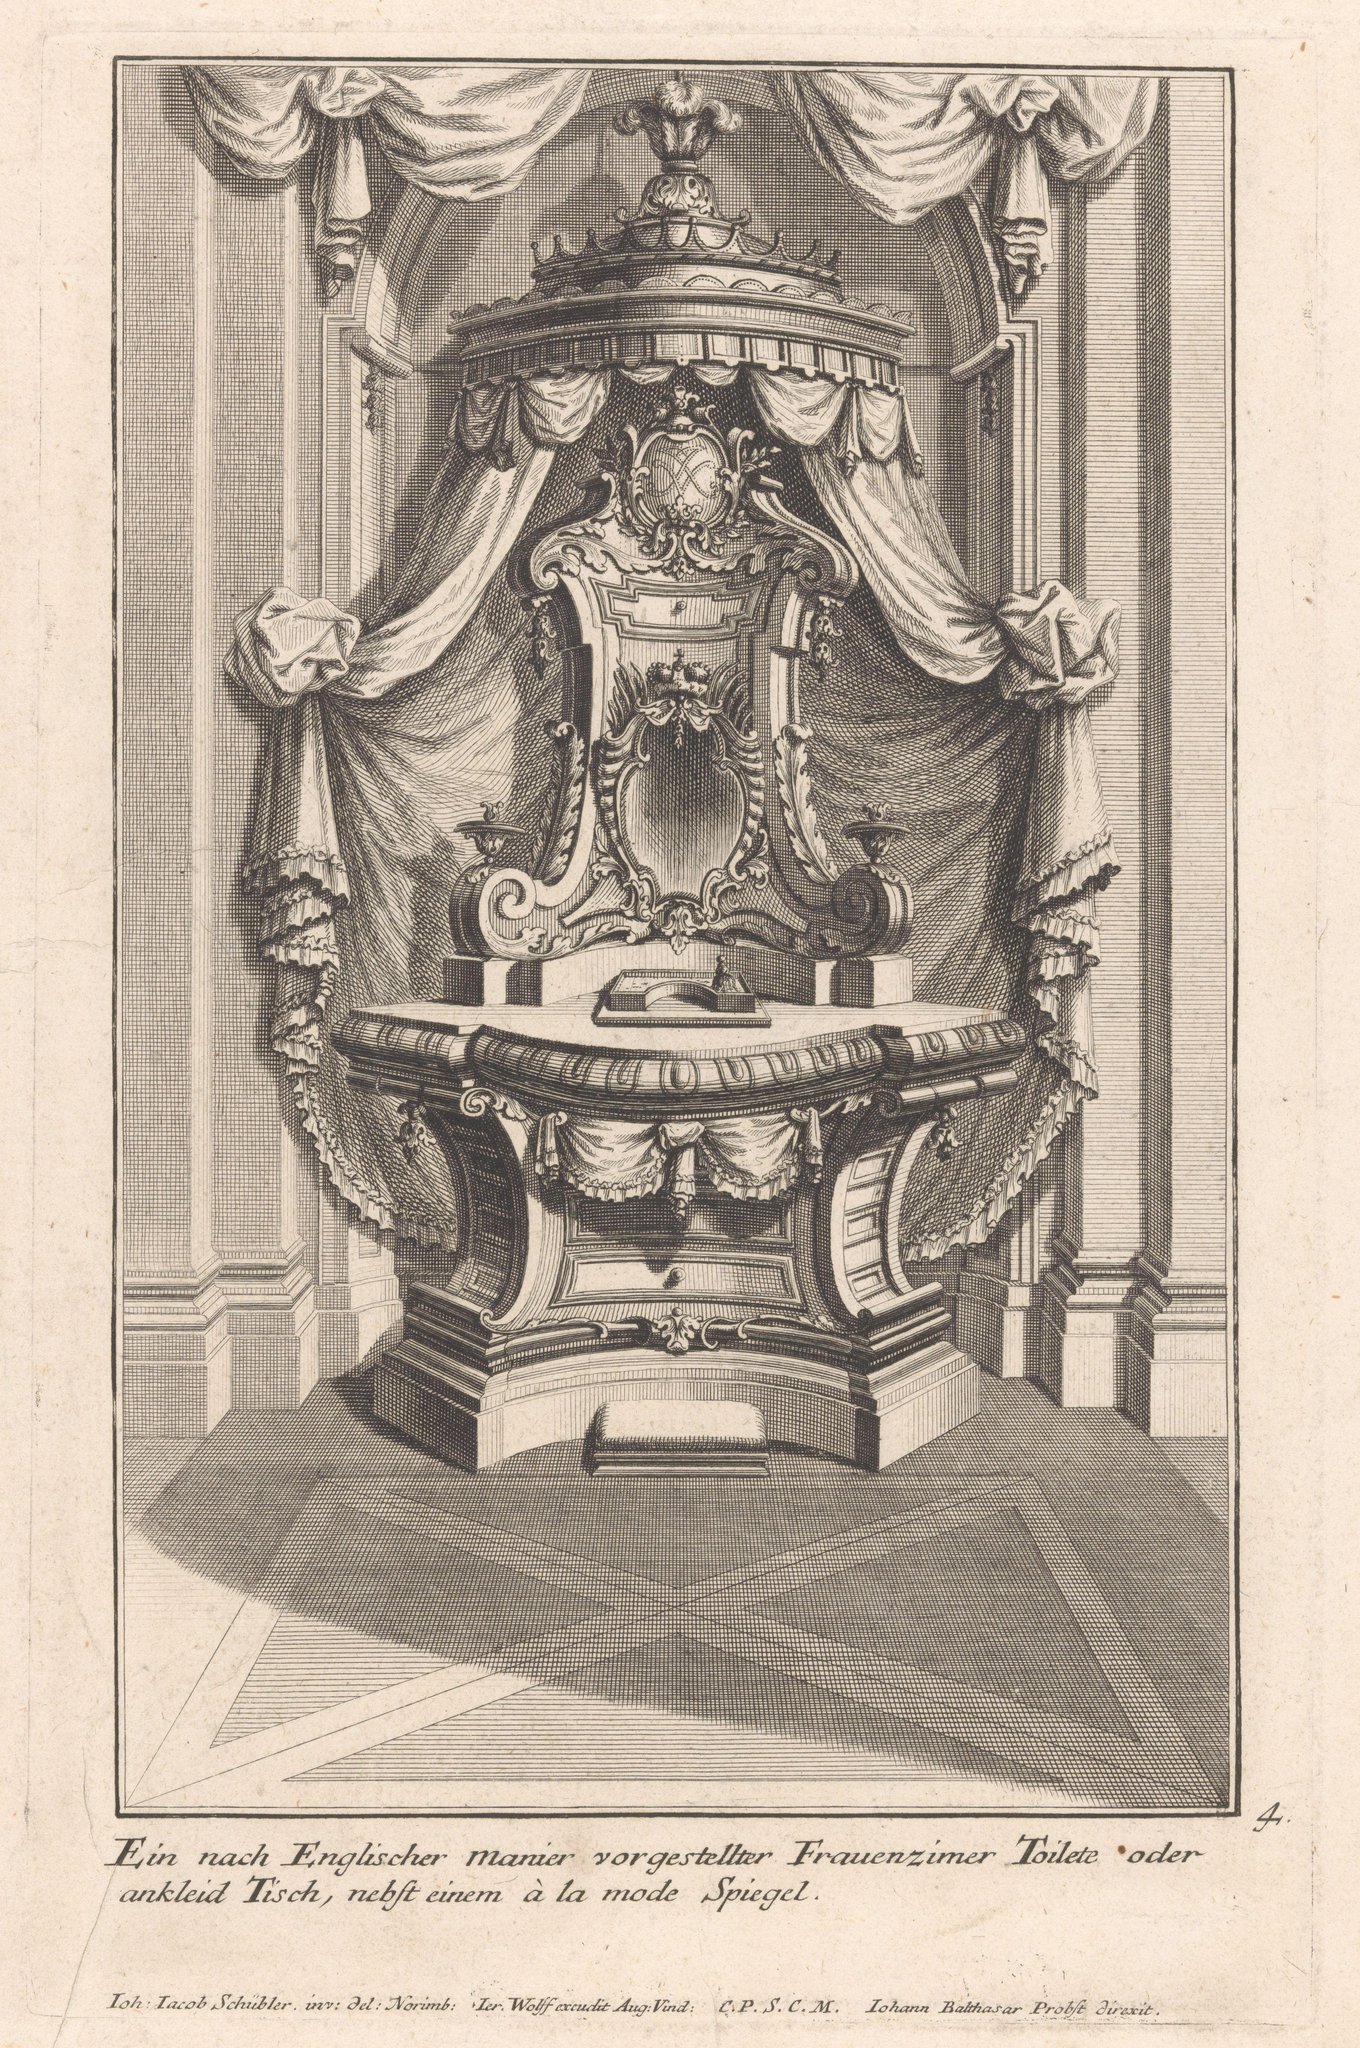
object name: ornament print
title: Johann Jacob Schüblers Vierdte Ausgab seines vorhabenden Wercks, Worinnen vorgestellet werden Neu-inventirte Schreib-Tische (...)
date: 1709-1724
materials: paper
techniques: engraving, etching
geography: nuremberg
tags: canopy, baldachin, making toilet - aa - (for) women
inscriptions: collector's mark: Lugt 2228, collector's mark: Lugt 2760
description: Prent uit: Schübler, Johann Jacob. Erste [-Zwanzigste] Ausgabe seines vorhabenden Wercks (...). Augsburg: Wolf, erven Jeremias, [na 1724]